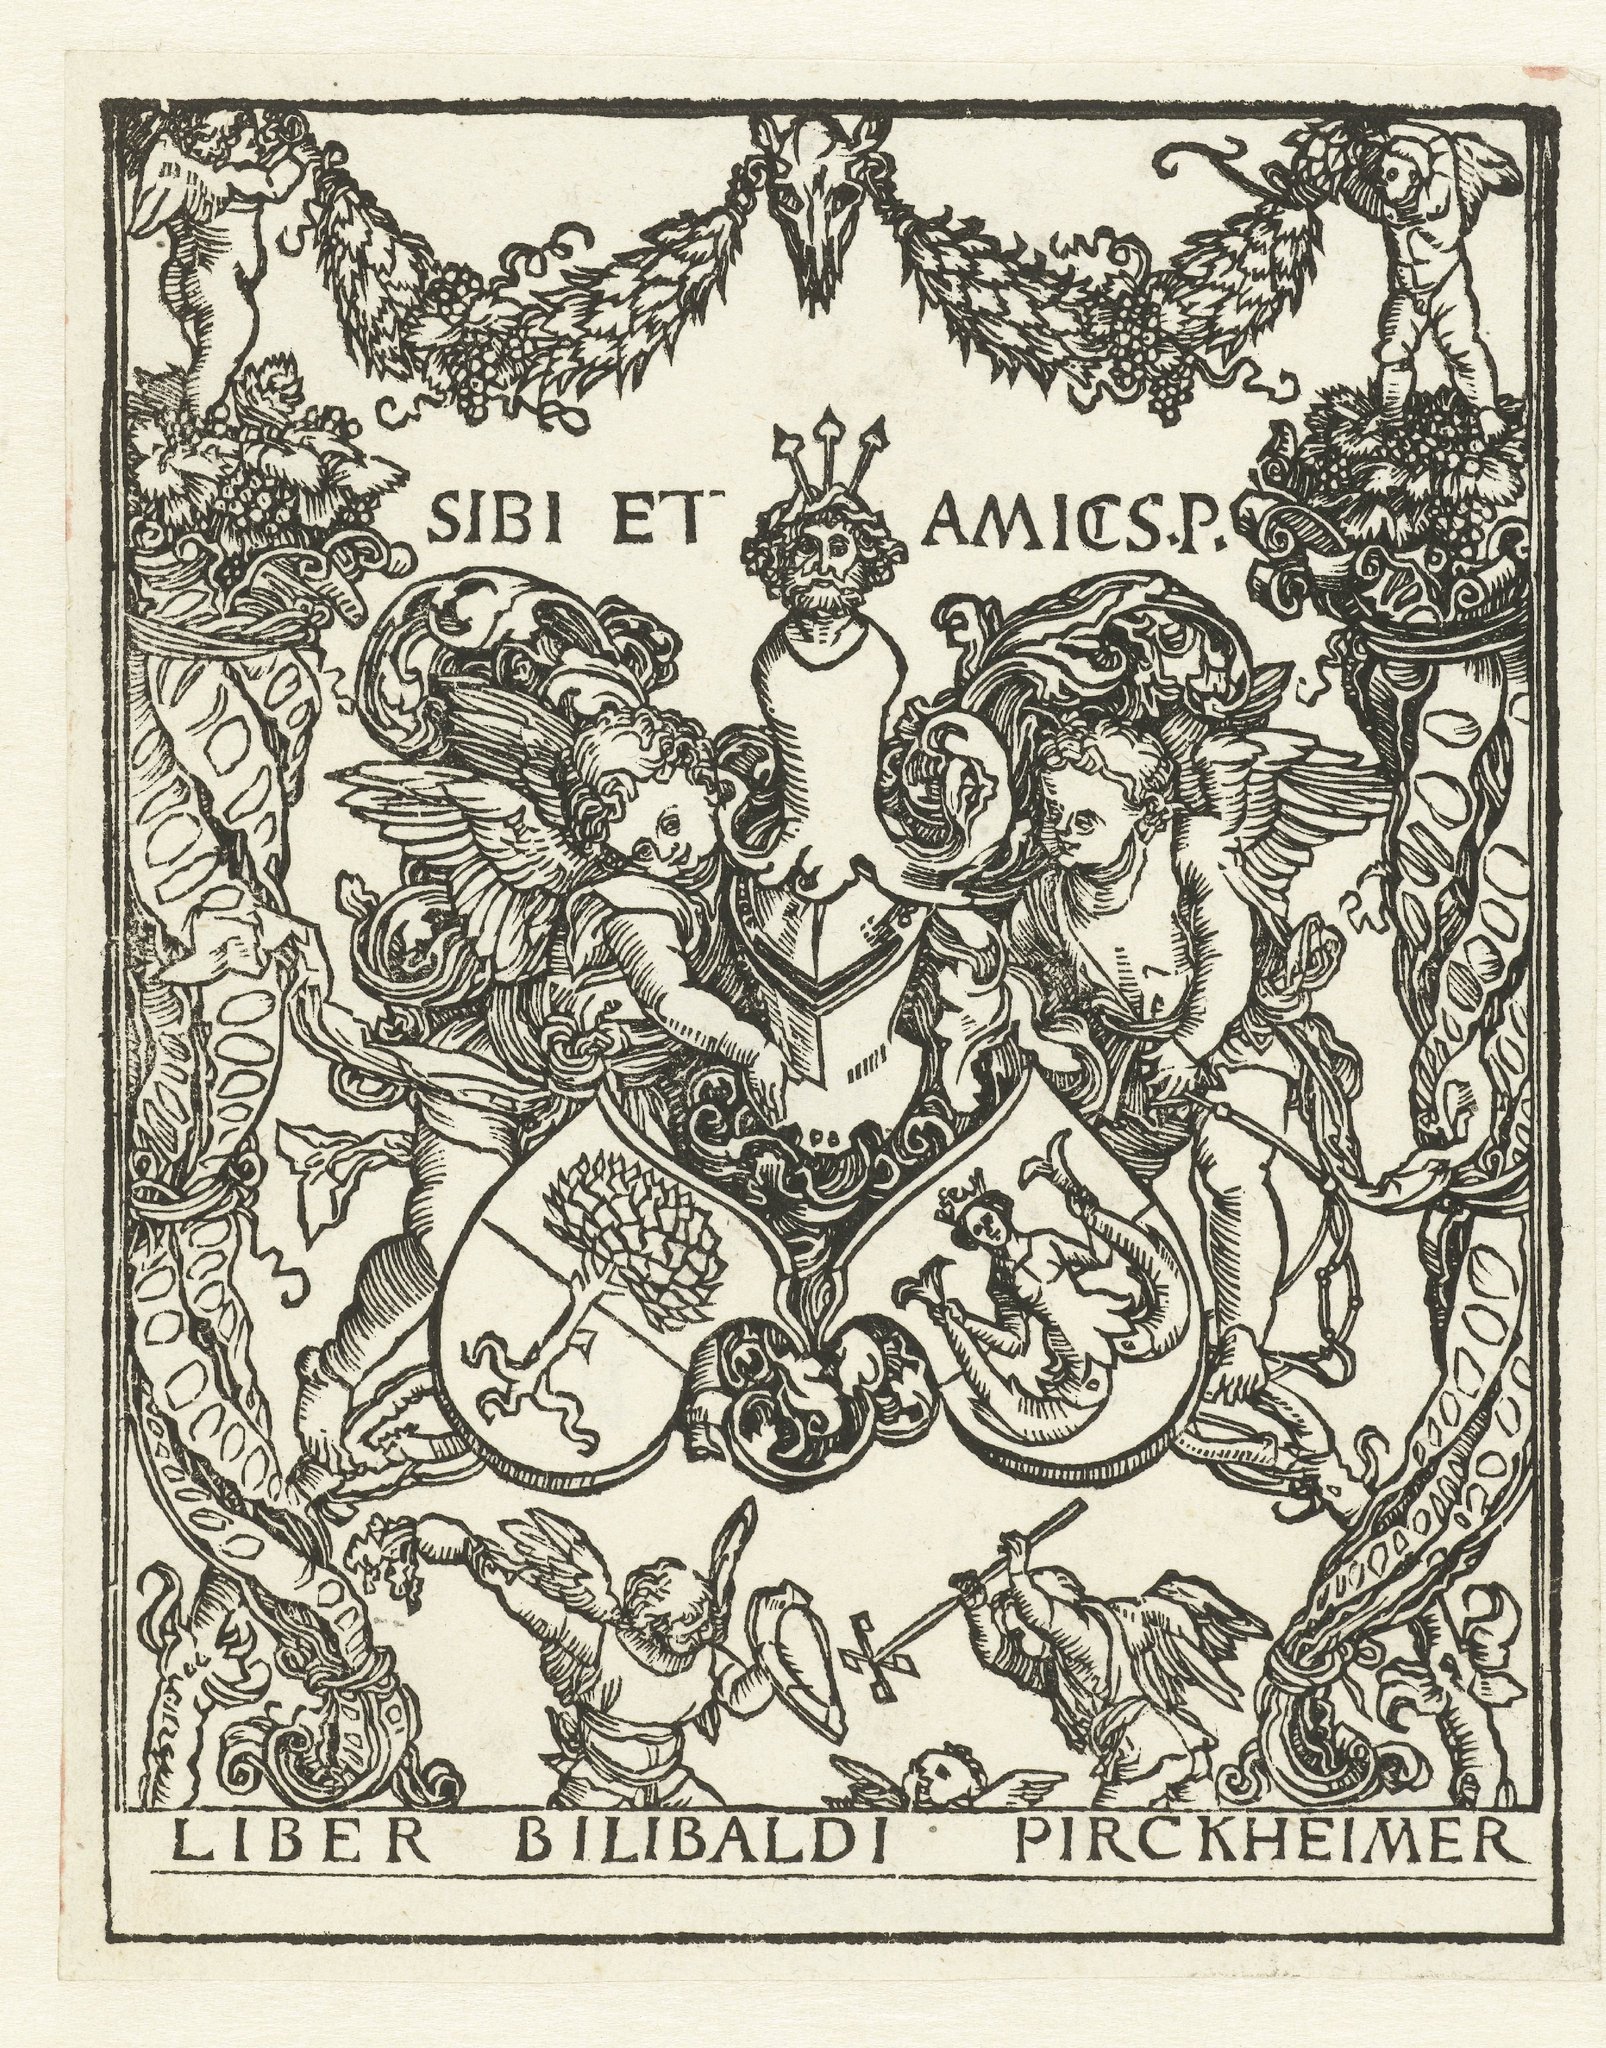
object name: bookplate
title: Ex libris Willibald Pirckheimer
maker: albrecht dürer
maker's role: draughtsman, painter, print maker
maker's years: 1471-1528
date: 1500-1504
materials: paper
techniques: woodcut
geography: nuremberg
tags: ex-libris, cupids: 'amores', 'amoretti', 'putti', armorial bearing, heraldry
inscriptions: collector's mark: Lugt 212, collector's mark: Lugt 2228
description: Twee wapenschilden, vastgehouden door twee engeltjes. Daarboven de spreuk 'Sibi et amicis p[ositus]'. Eronder de tekst 'Liber Bilibaldi Pirckheimer'. Het geheel in een omlijsting van guirlandes, hoornen des overvloeds en putti.